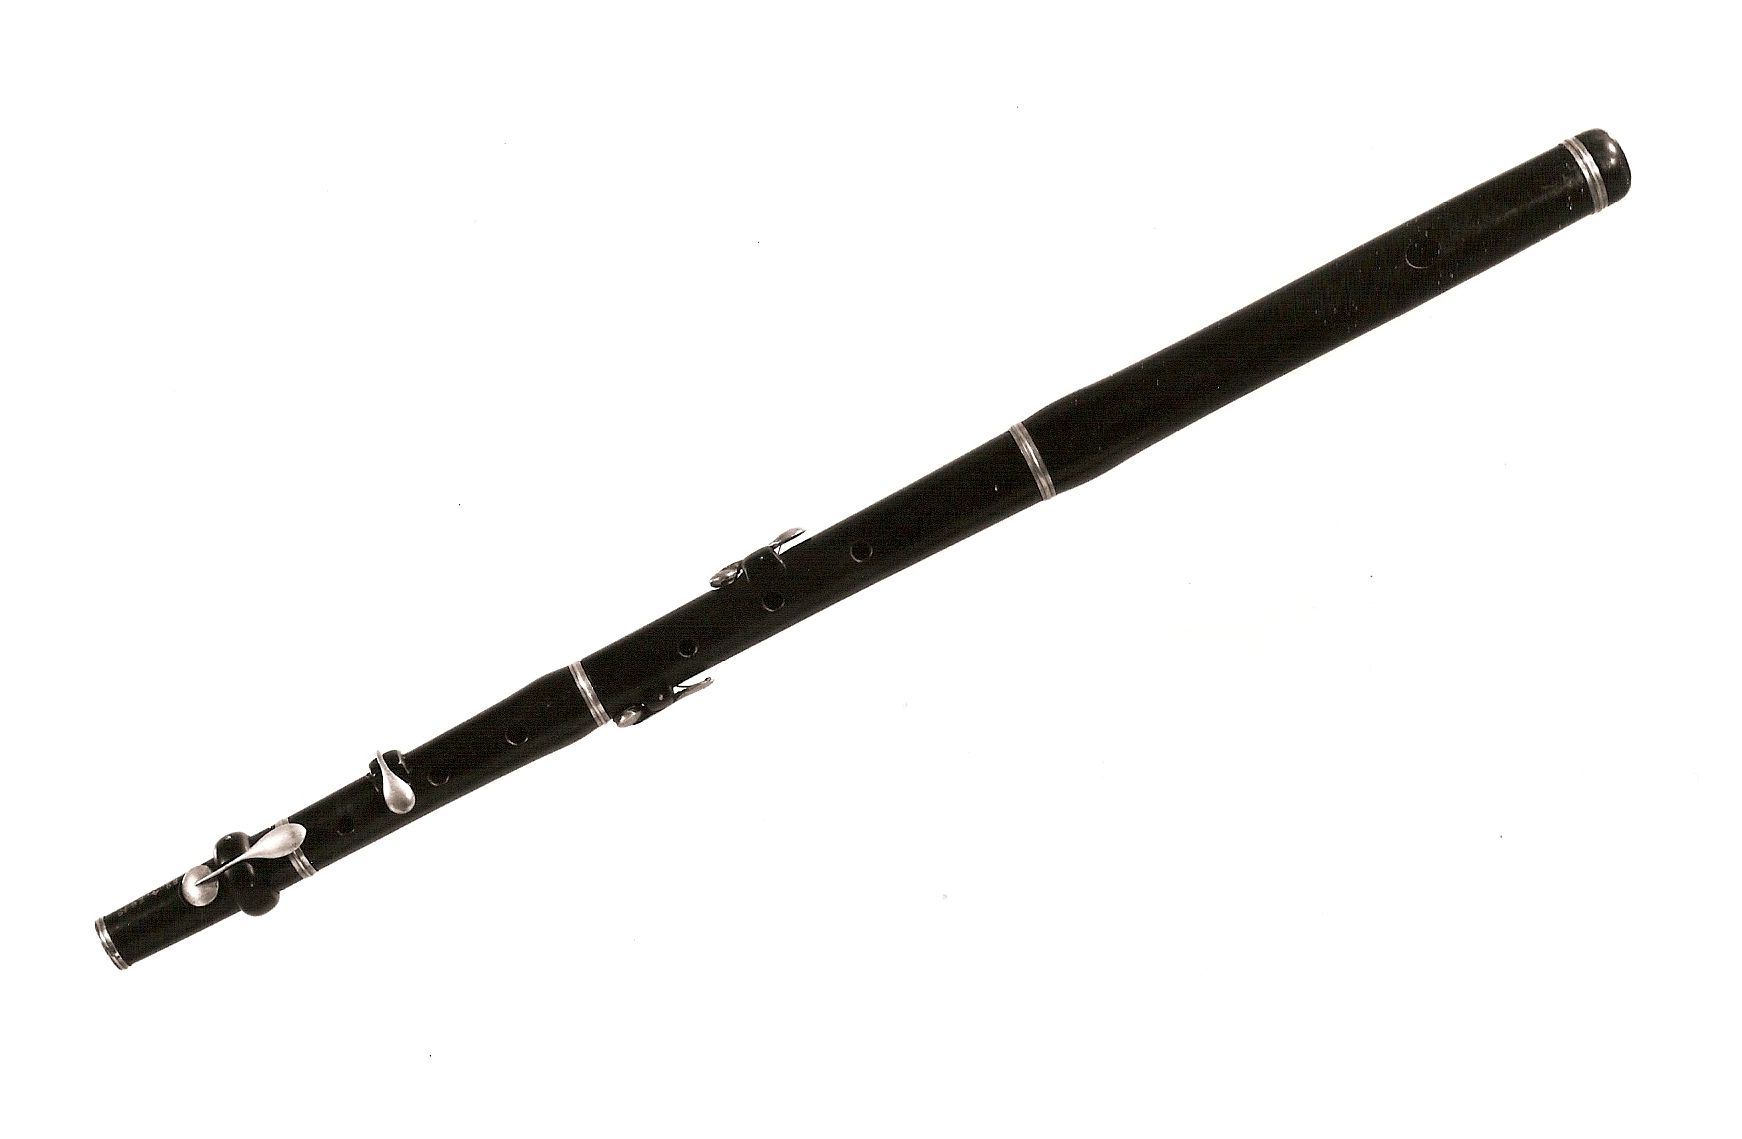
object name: flute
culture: american or european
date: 1834-1866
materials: wood, nickel, silver